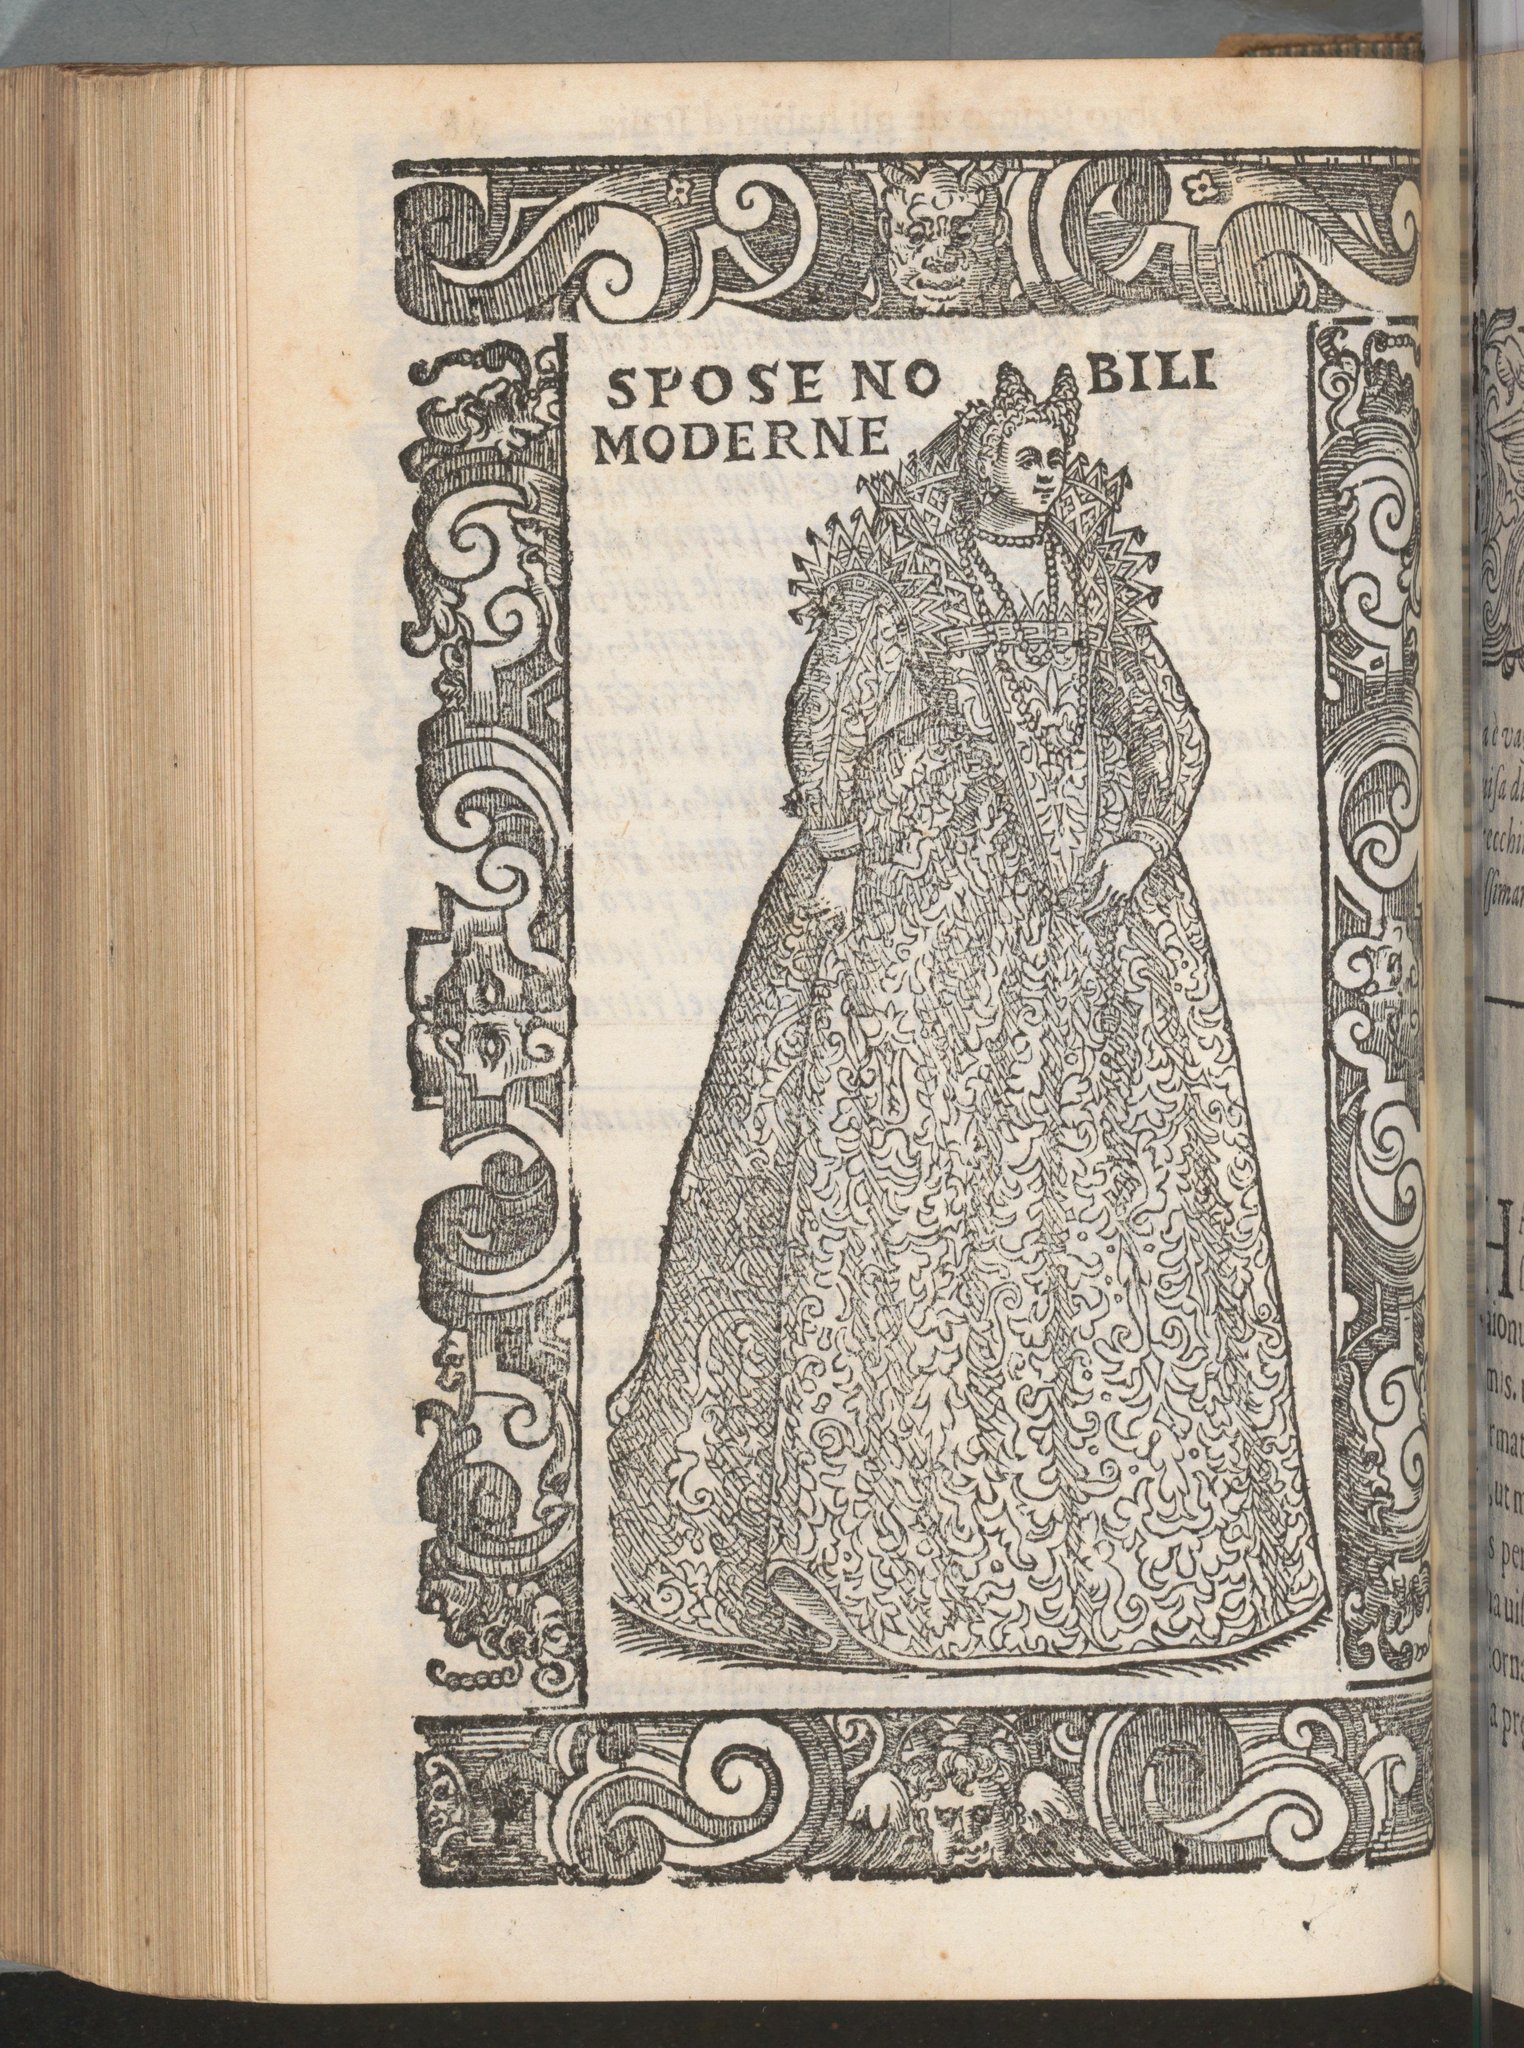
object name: costume print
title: Spose nobili moderne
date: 1598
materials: paper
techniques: woodcut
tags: styles of hairdress - aa - ~ women, neck-gear: collar (+ women's clothes), fashion plates, dress, gown (+ women's clothes), clothing for the upper part of the body (with name) (+ women's clothes), pearl; pearl necklace (+ women's clothes)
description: Venetiaanse, pas getrouwde vrouw, het kapsel in de 'moderne' haarstijl, waarbij het is gevormd in twee 'horentjes', als symbool van de kuisheid. Overkleed met rijk geborduurd puntlijfje en hoog opstaande kraag van opengewerkt kant. Parelsnoeren om de hals. In ornamentrand